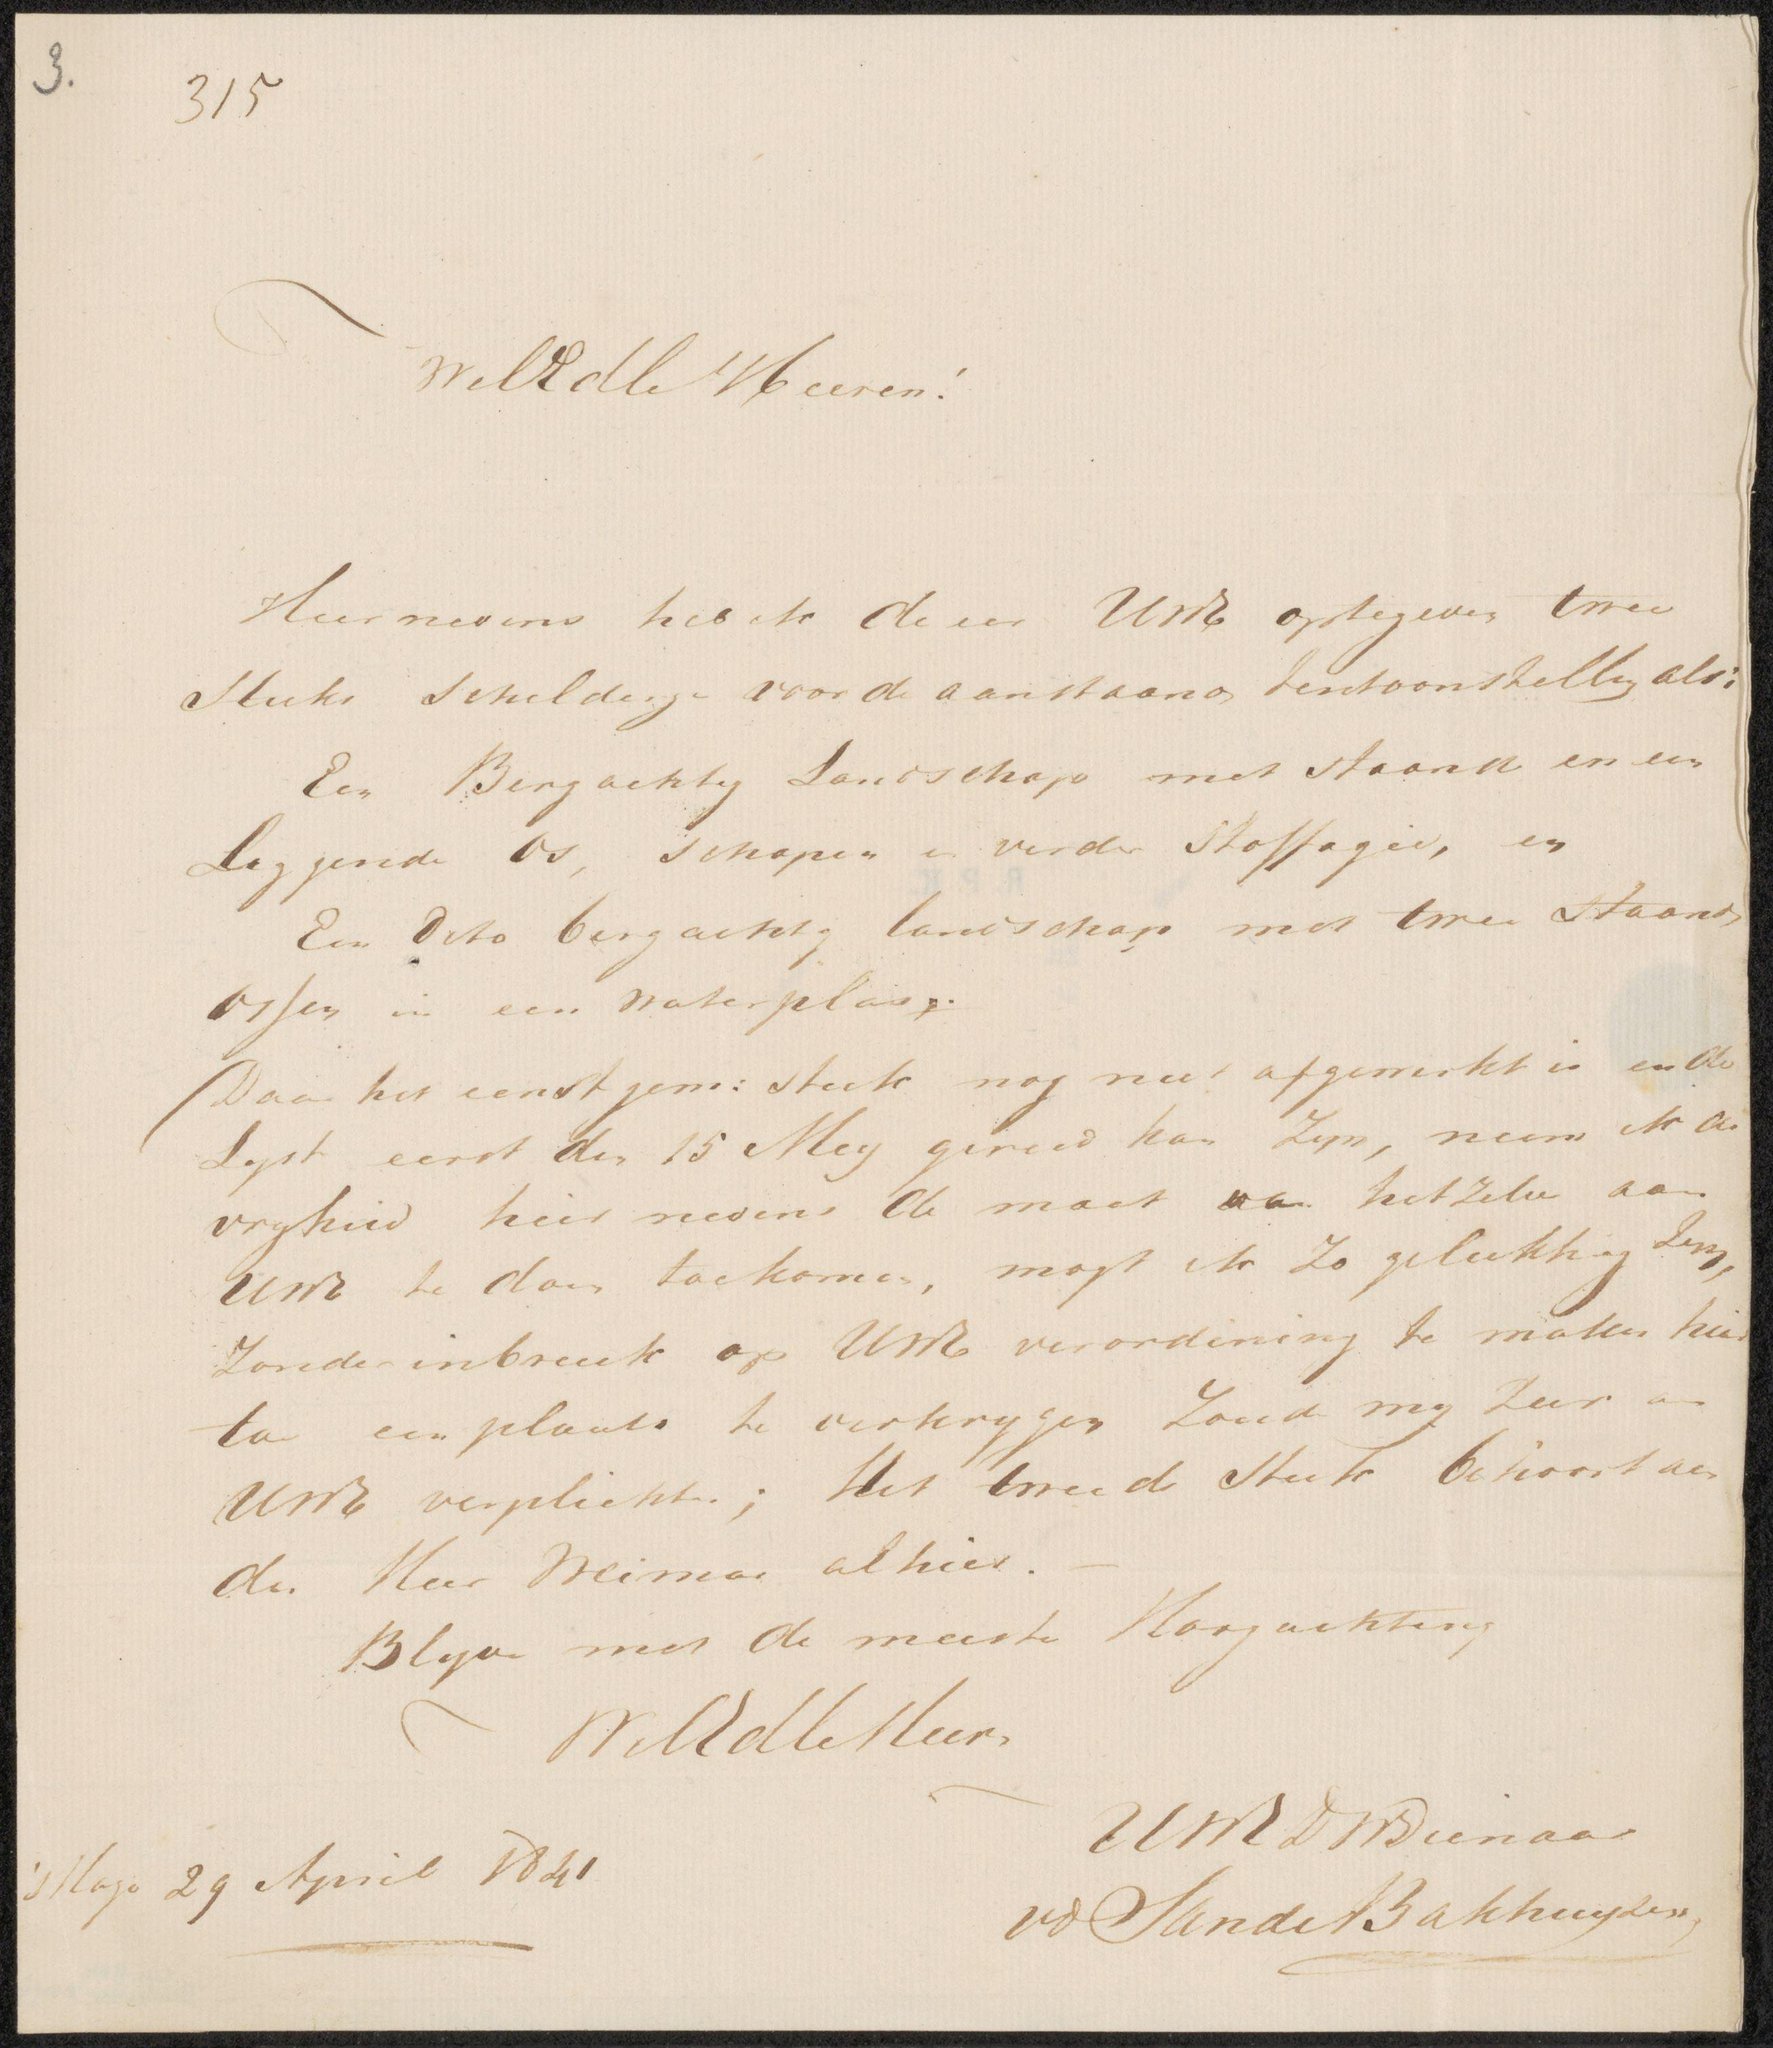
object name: letter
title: Brief aan de Commissie van de Tentoonstelling van Levende Meesters in Den Haag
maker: hendrikus van de sande bakhuyzen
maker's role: draughtsman, painter, print maker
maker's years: 1795-1860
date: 1841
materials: ink, paper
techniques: pen, writing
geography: the hague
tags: painting (including book-illumination, miniature-painting), exhibition ~ art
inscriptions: collector's mark: Lugt 2233, watermark